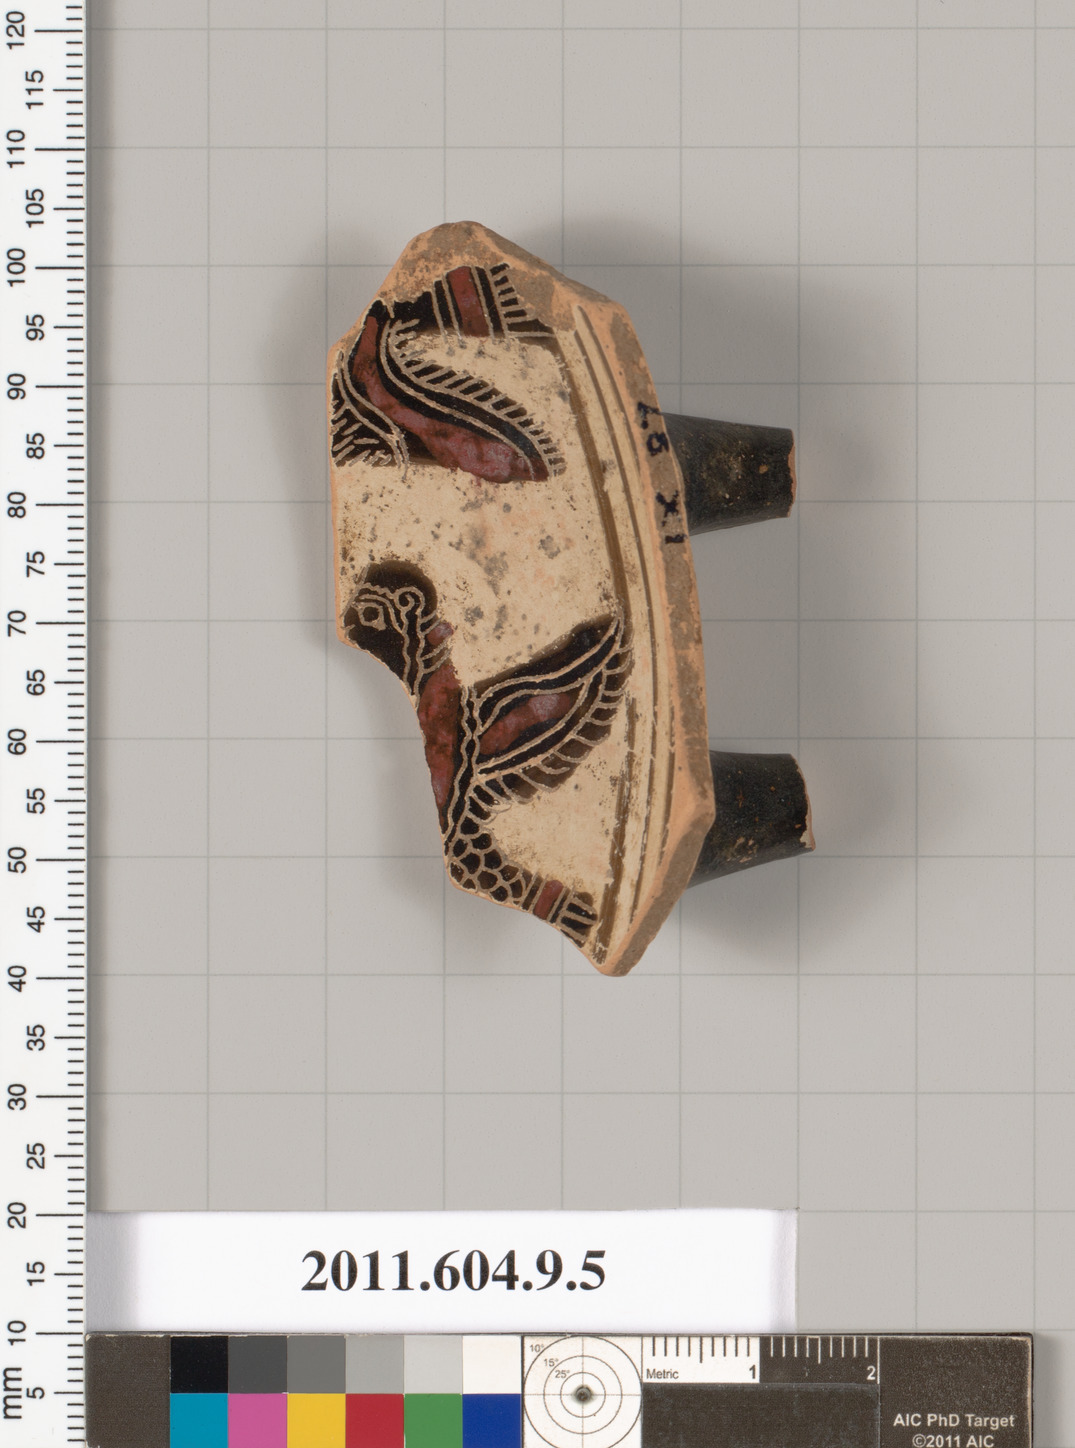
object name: kylix fragment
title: Terracotta fragment of a kylix (drinking cup)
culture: greek, laconian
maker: rider painter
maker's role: artist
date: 567-535 BCE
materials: terracotta